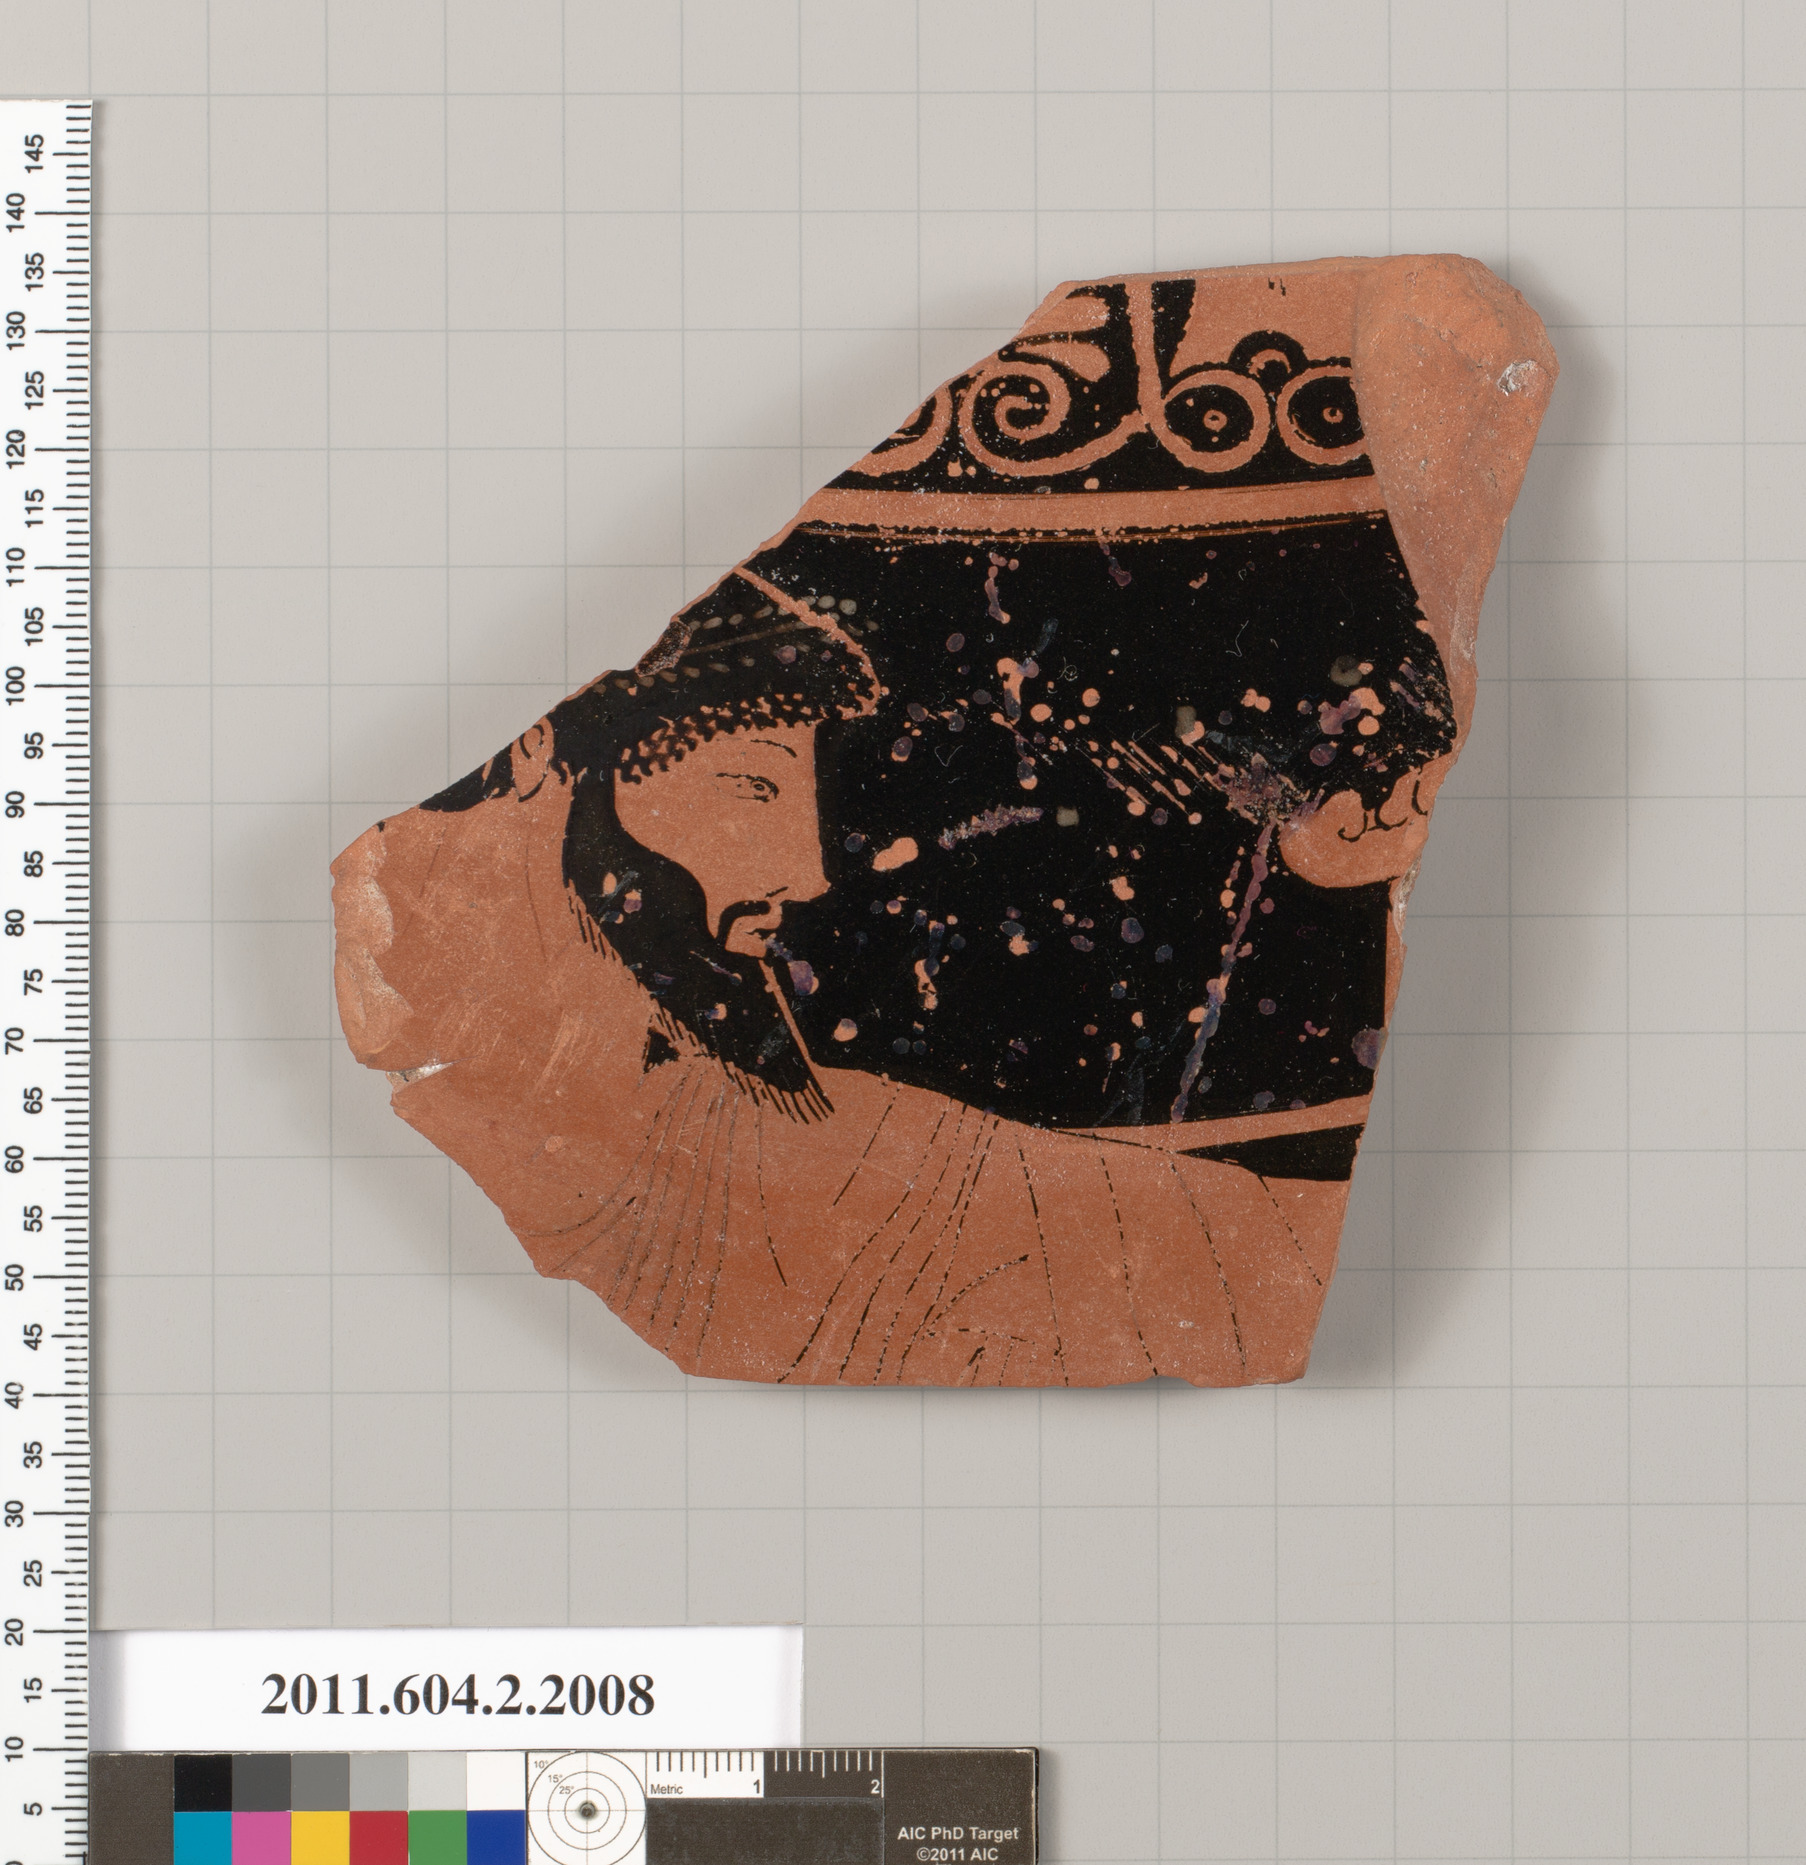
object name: amphora fragment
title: Terracotta fragment of an amphora (jar)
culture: greek, attic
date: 510-500 BCE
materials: terracotta